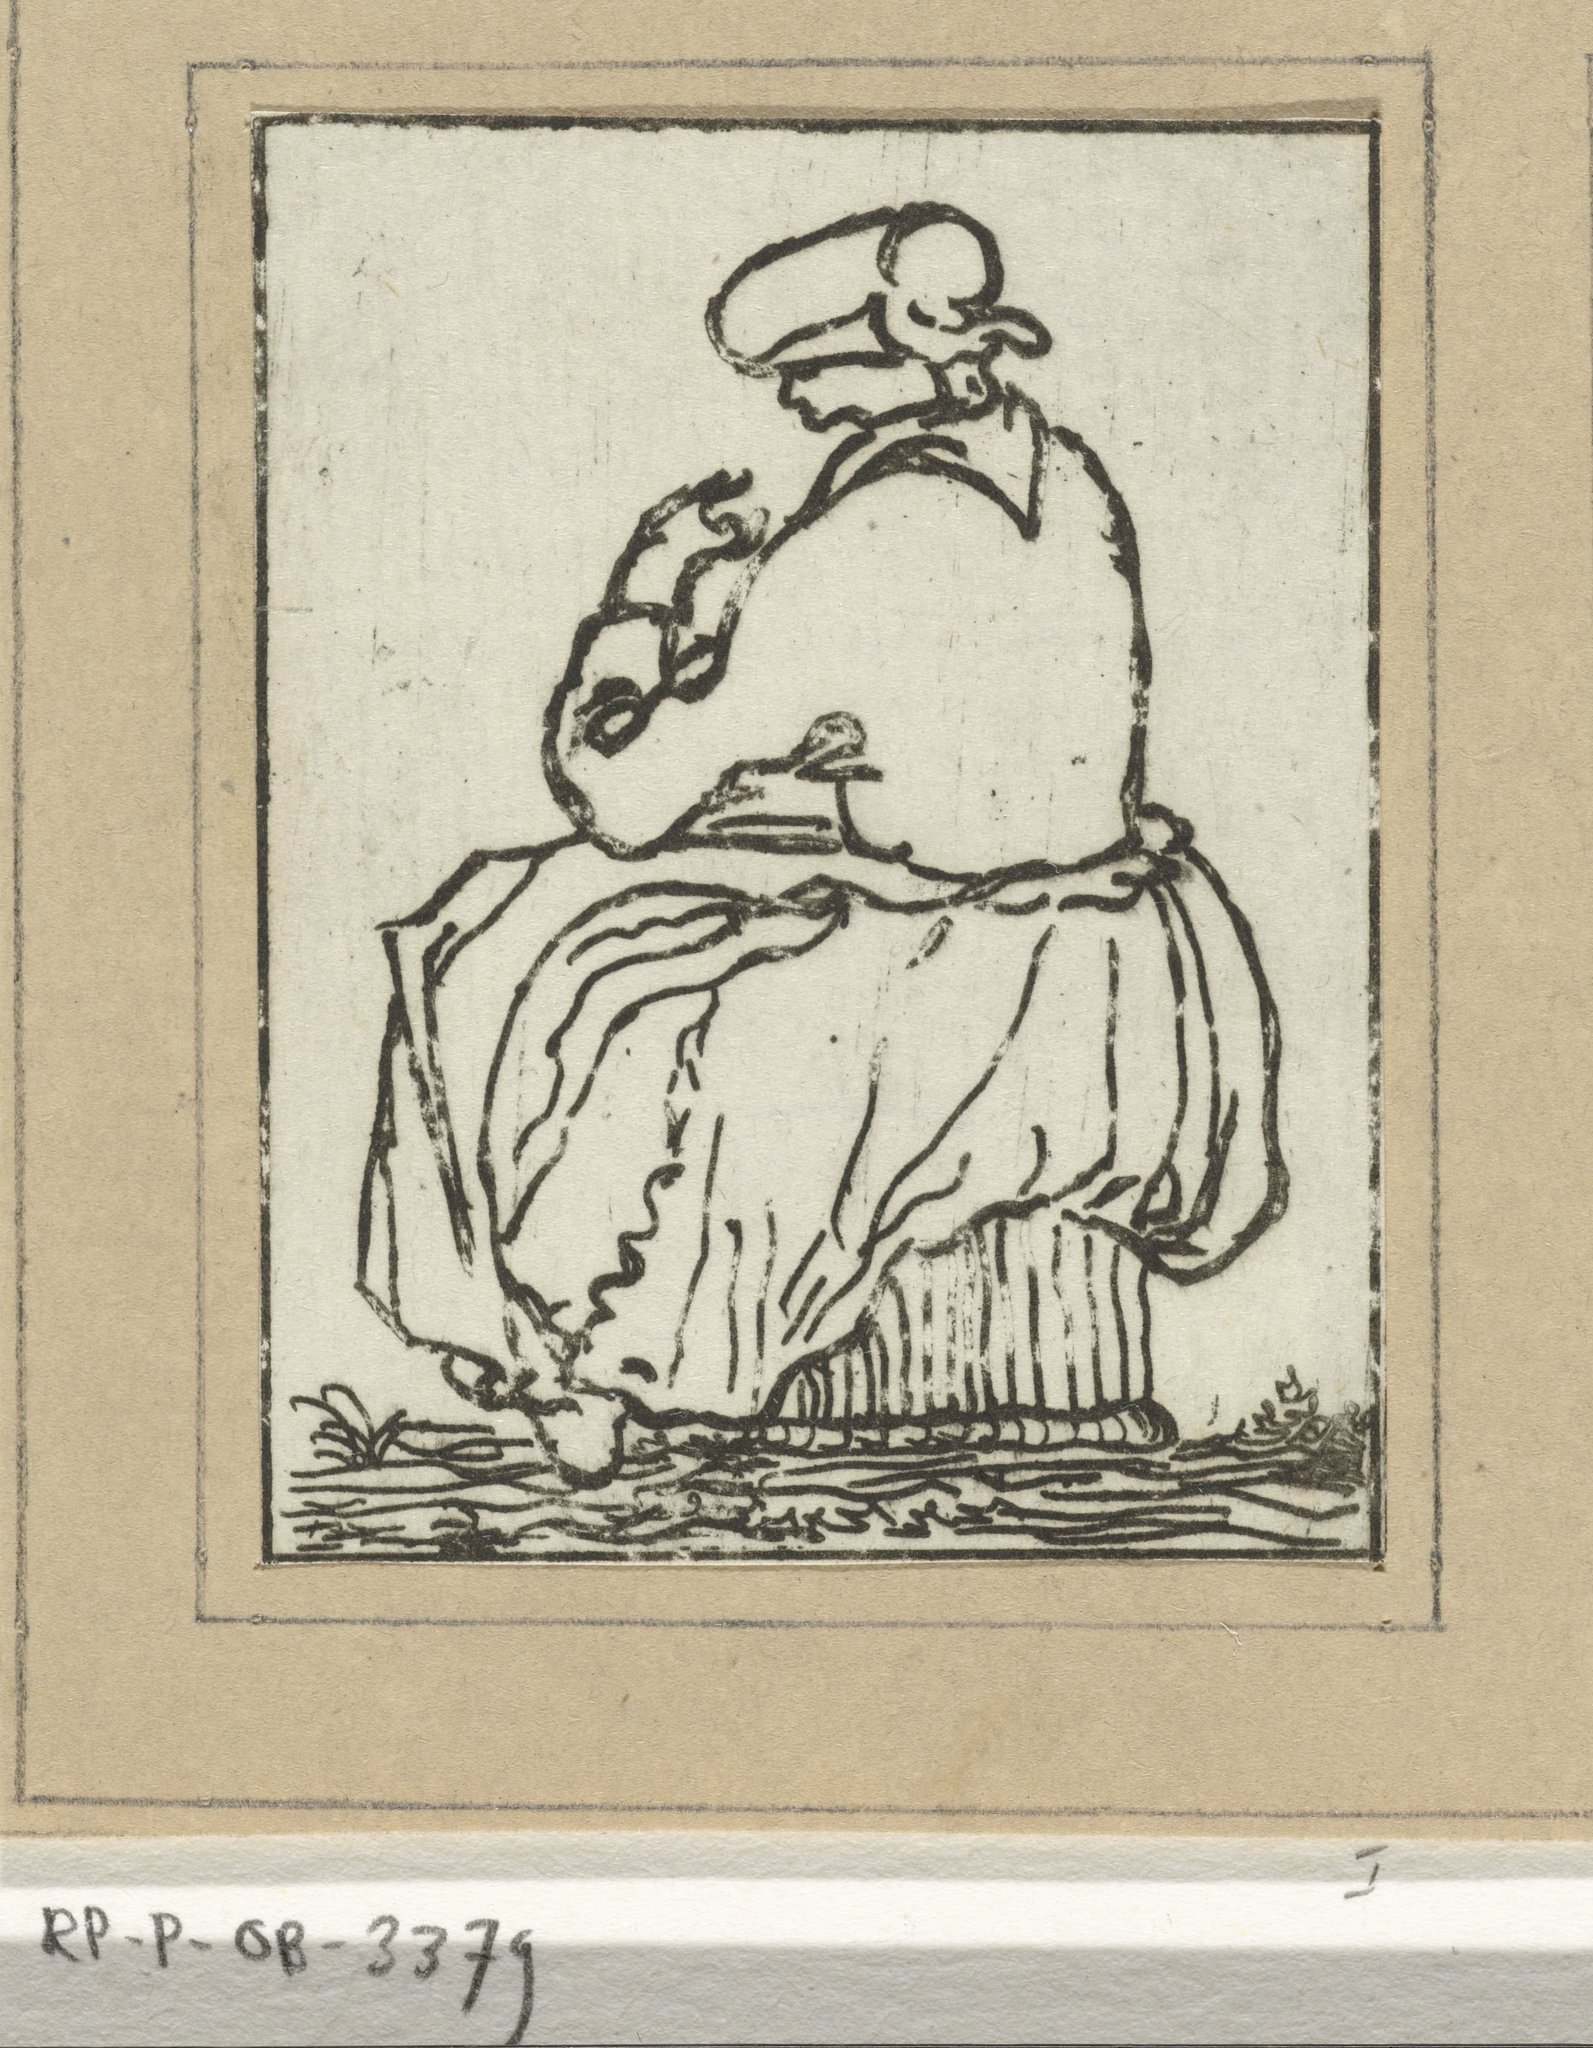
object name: print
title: Zittende boerin op de rug gezien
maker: jacob hoolaart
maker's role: print maker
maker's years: 1713-1789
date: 1728-1789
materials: paper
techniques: etching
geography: dordrecht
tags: sitting figure - aa - female human figure